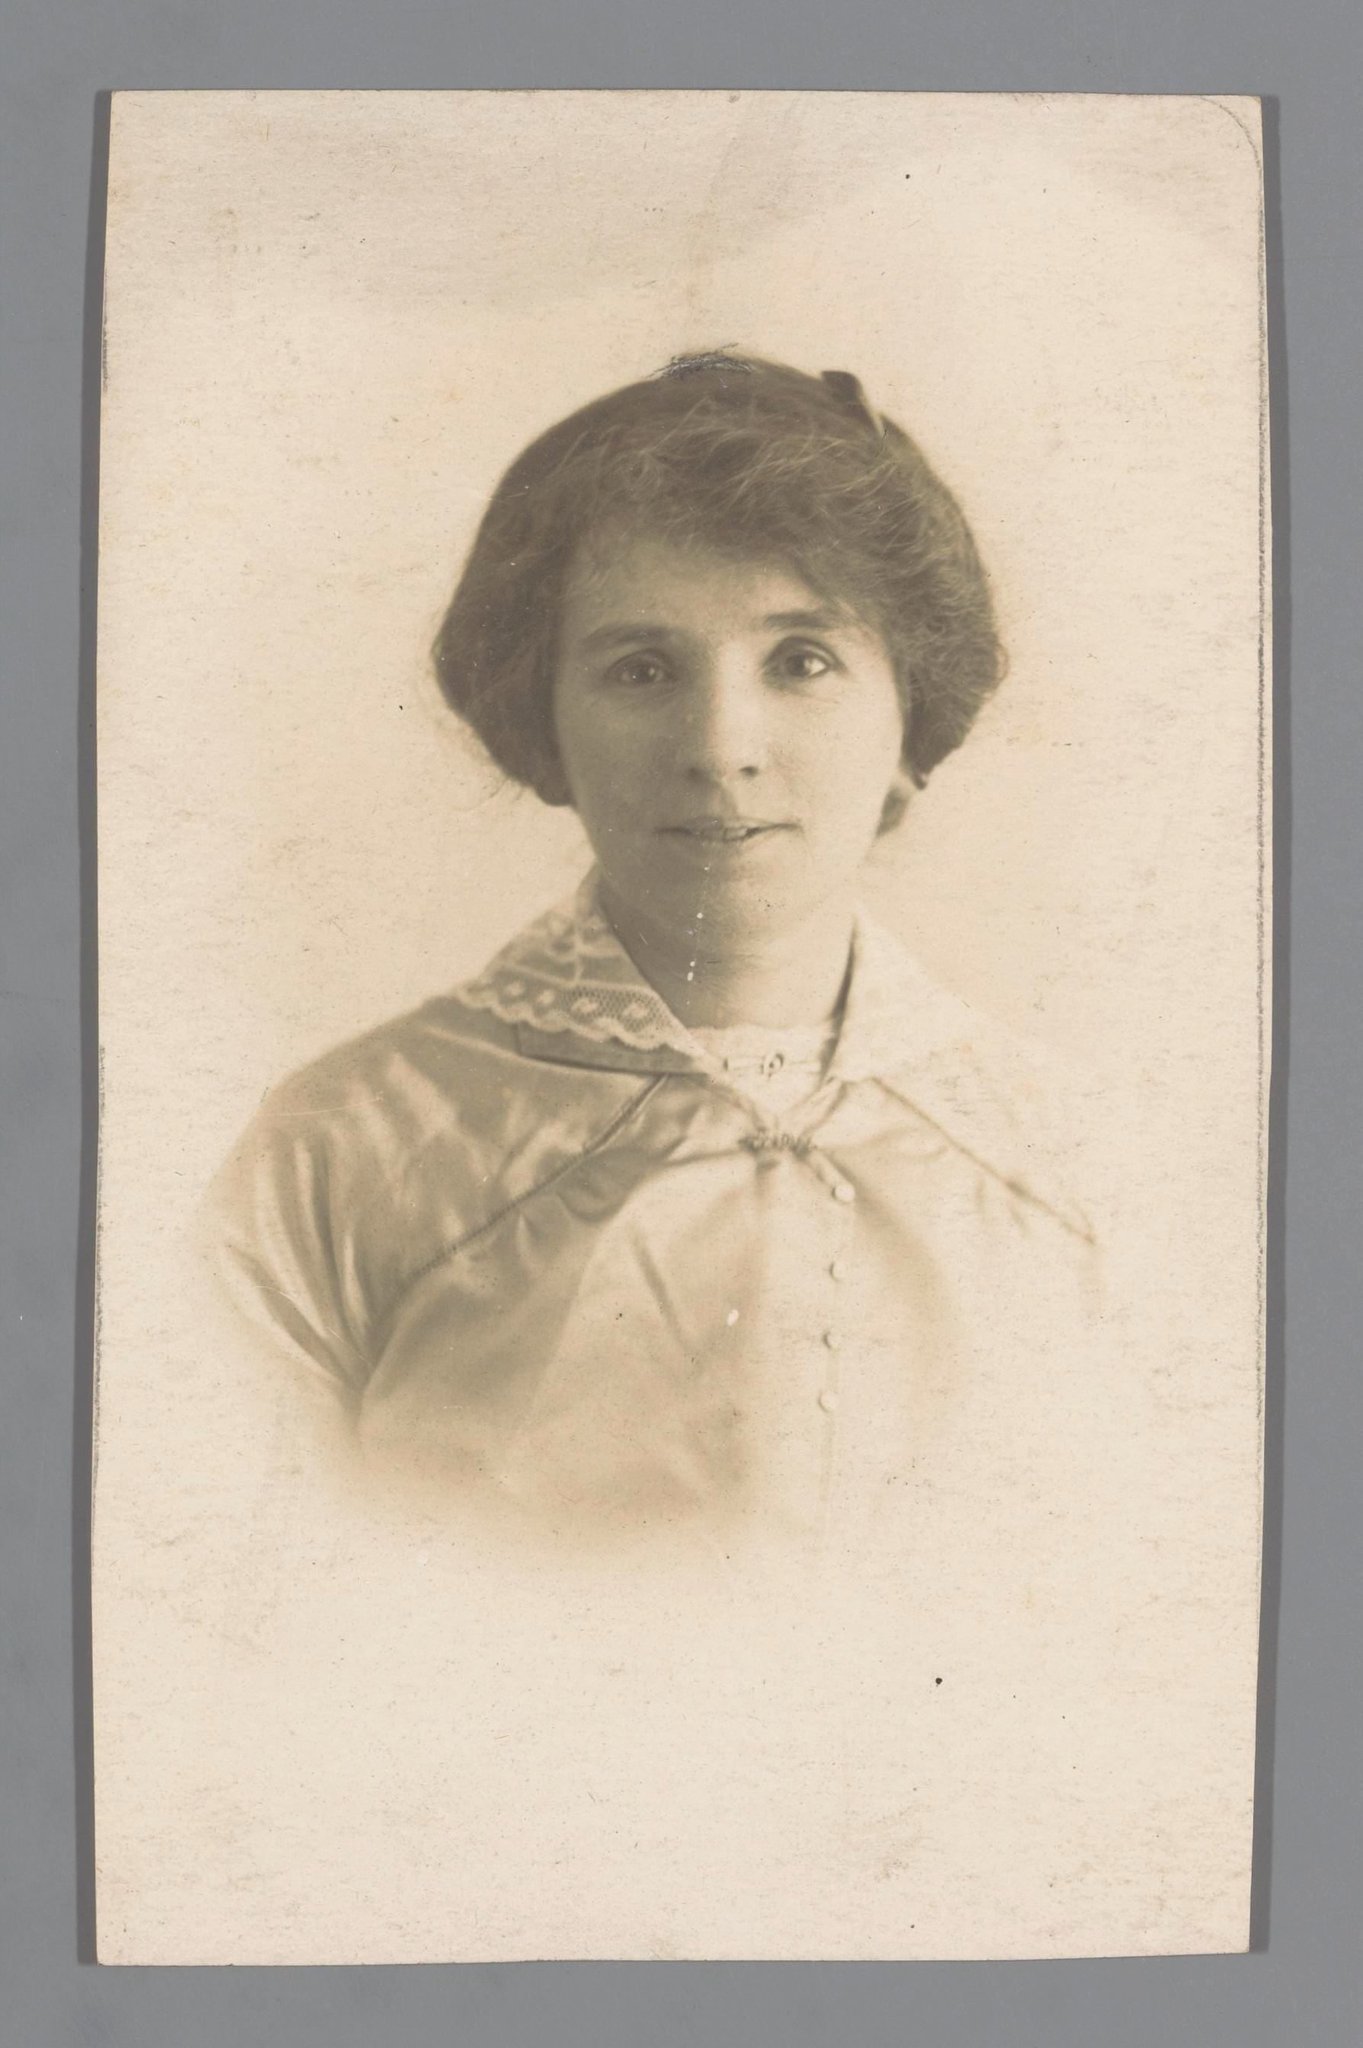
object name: photograph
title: Portret van een onbekende vrouw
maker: Anonymous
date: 1860-1900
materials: photographic support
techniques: daylight paper print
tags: adult woman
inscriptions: inscription: ‘Post Card Correspondence Address’